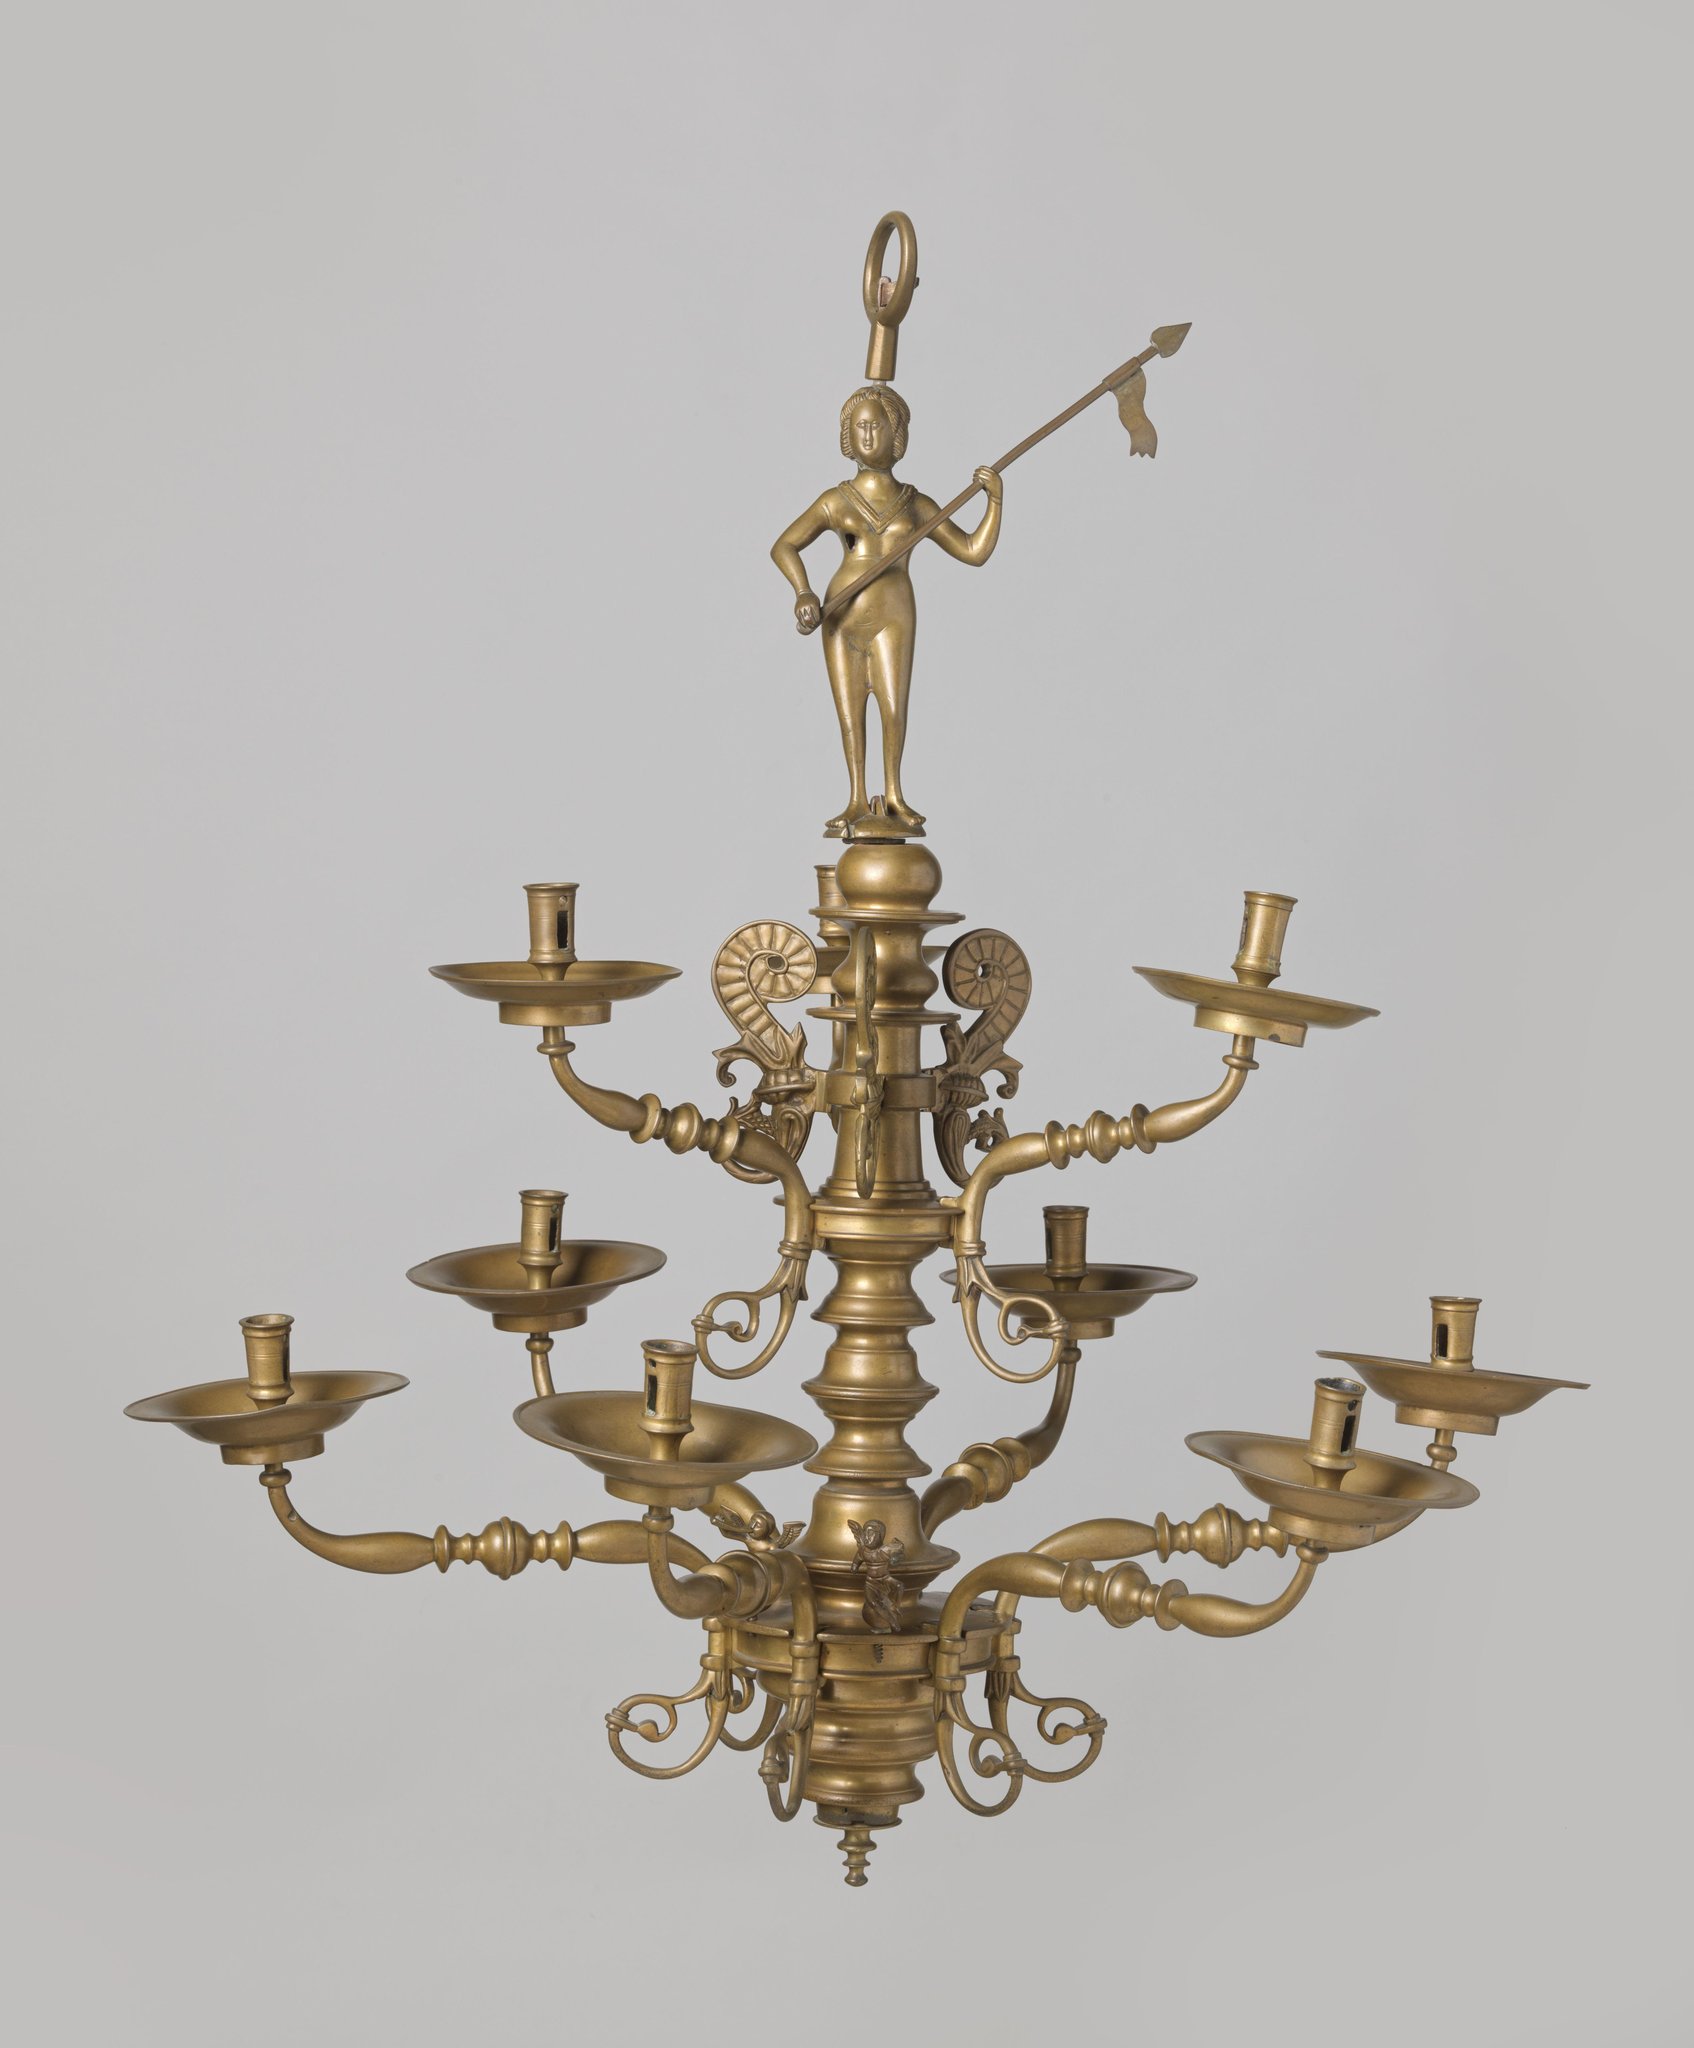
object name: chandelier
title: Arm met kaarsenhouder van kaarsenkroon van twee hoogten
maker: Anonymous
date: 1525-1575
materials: brass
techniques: casting, screwed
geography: north germany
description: Kaarsenarm behorende bij een kaarsenkroon van twee hoogten met naakte vrouw bovenaan. De arm heeft in het midden een bol- en holrond geprofileerde nodus en verdikt zich een weinig aan weerszijden. Bij de stam loopt zij uit in een spiraalvormige krul. Naar buiten toe mondt zij uit in het schroefeind van ijzer. Daarop bevindt zich de ronde vetvanger met onderaan een afstaande rand. De ronde in elkaars verlengde opengewerkte kaarsenhouder heeft een holronde voet, die op de arm is geschroefd. Dit is de eerste arm van de bovenste ring, genummerd met 1 driehoekige punt. De kaarsenhouder is ongenummerd.